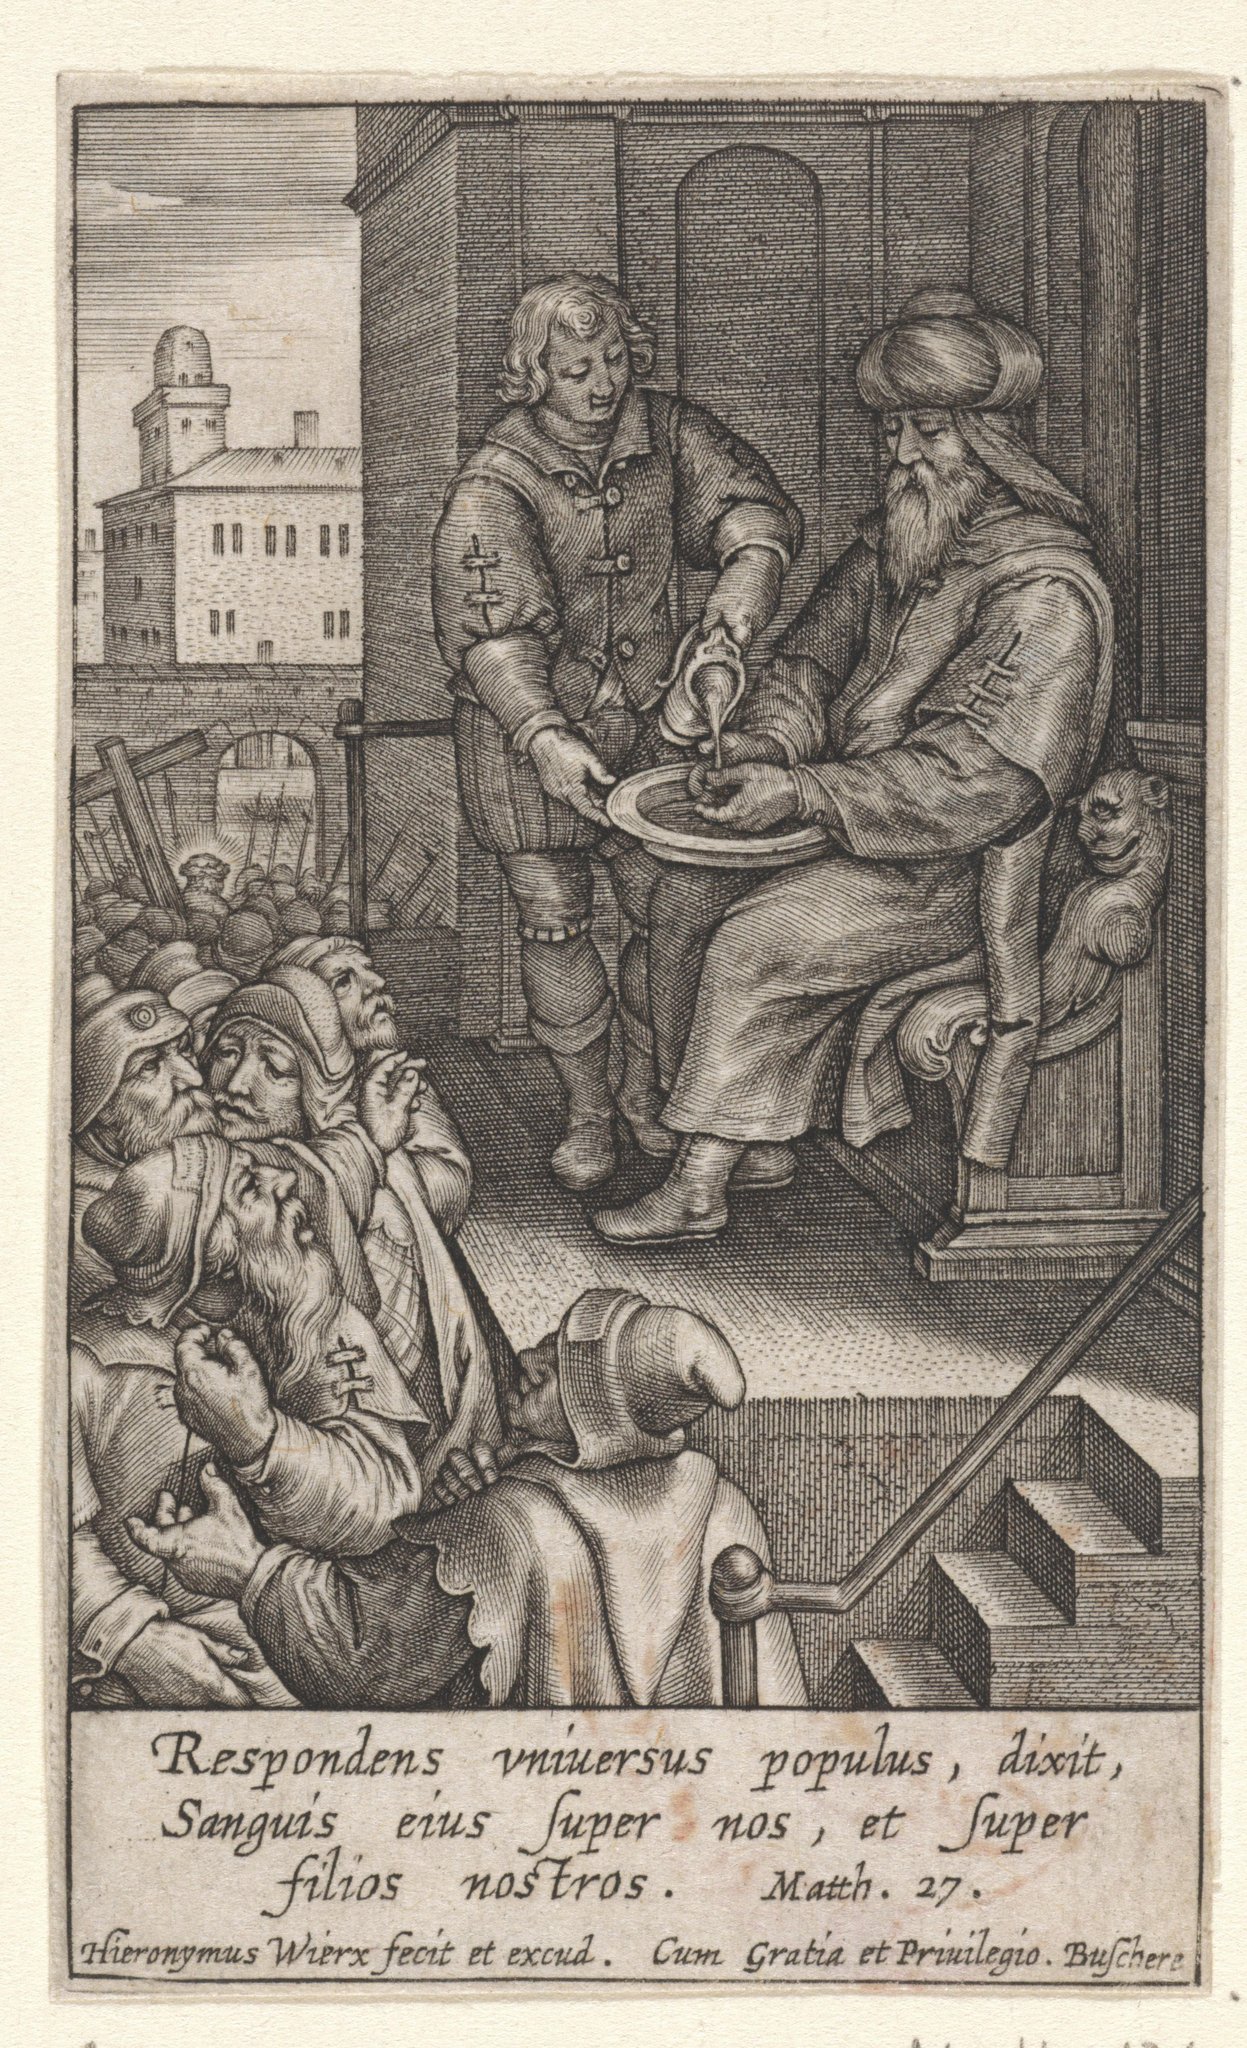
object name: print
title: Pilatus wast zijn handen in onschuld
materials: paper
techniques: engraving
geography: antwerp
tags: pilate washing his hands (in innocence)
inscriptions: collector's mark: Lugt 240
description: Pilatus wast zijn handen in onschuld. Ten overstaan van de menigte wast hij zijn handen in een schaal met water. Op de achtergrond is te zien dat Christus wordt afgevoerd nadat hij ter dood is veroordeeld. In de marge een drieregelig Bijbelcitaat uit Mat. 27 in het Latijn.